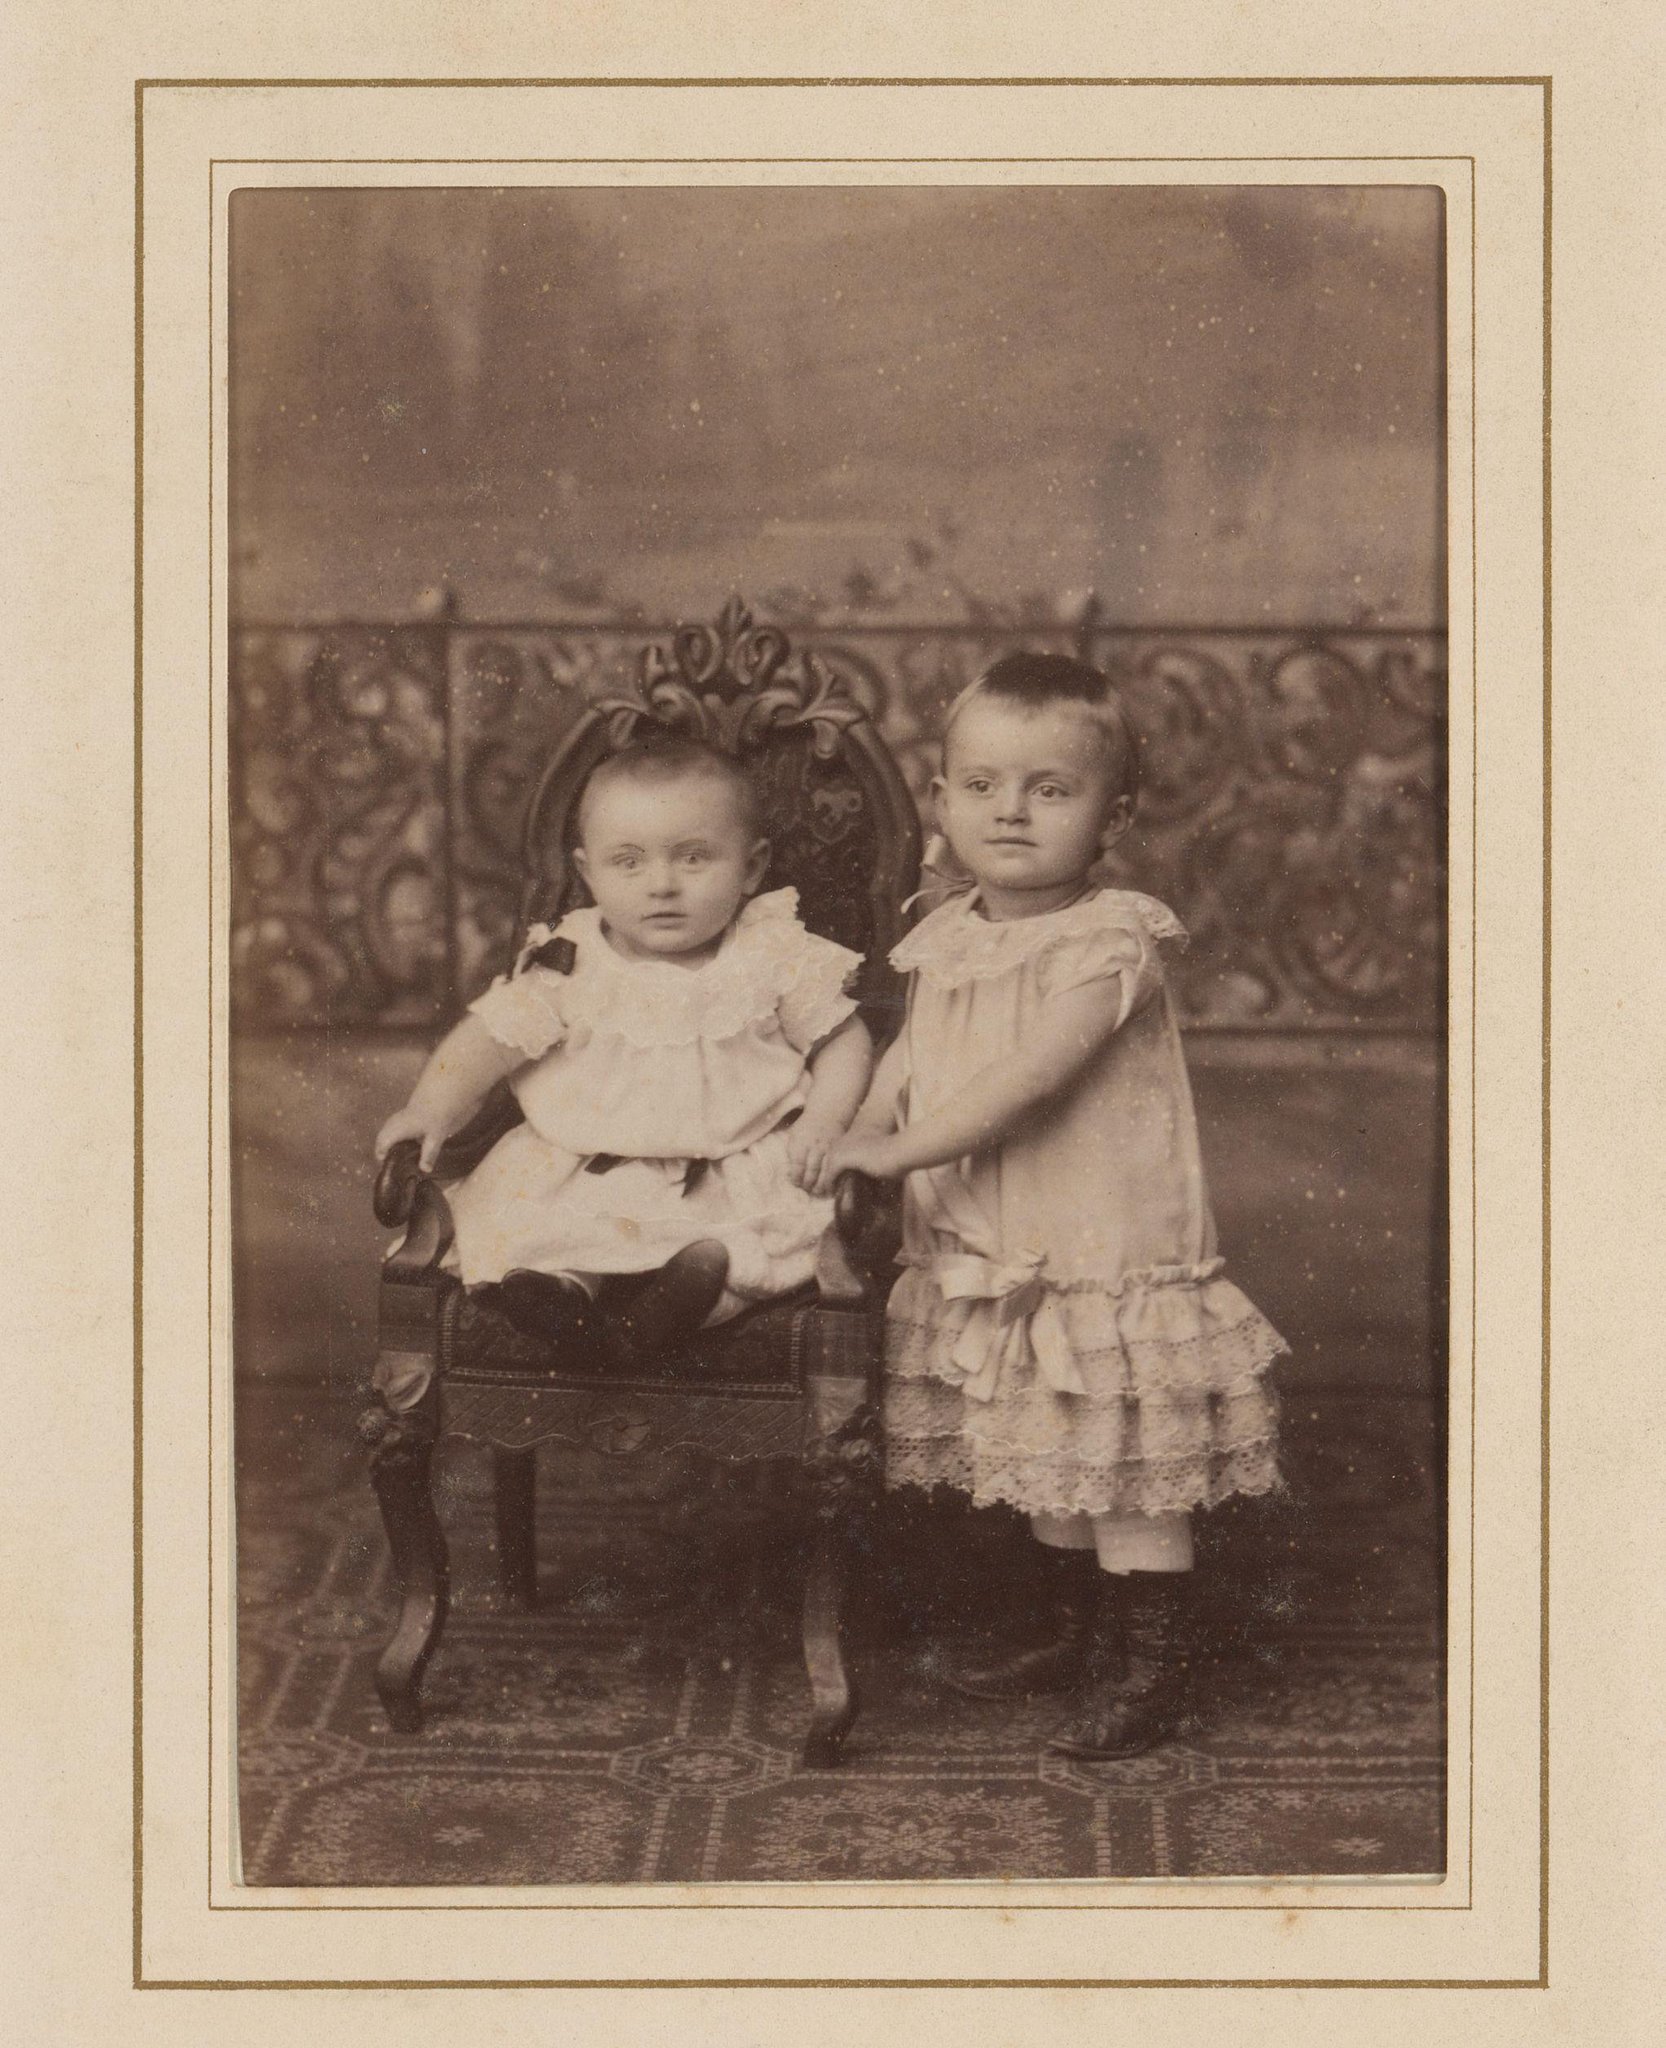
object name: photograph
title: Portret van twee peuters, waarvan één zittend op een stoel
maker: wilh. lange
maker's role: fotograaf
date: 1884-1900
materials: cardboard, photographic support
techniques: albumen print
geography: speyer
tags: historical persons - bb - woman, toddler (female) (+ two persons), chair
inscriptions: inscription: ‘W. LANGE/ Photographie Atelier/ SPEYER a/ Rh., FRANKENTHAL/ u./ GRÜNSTADT.’